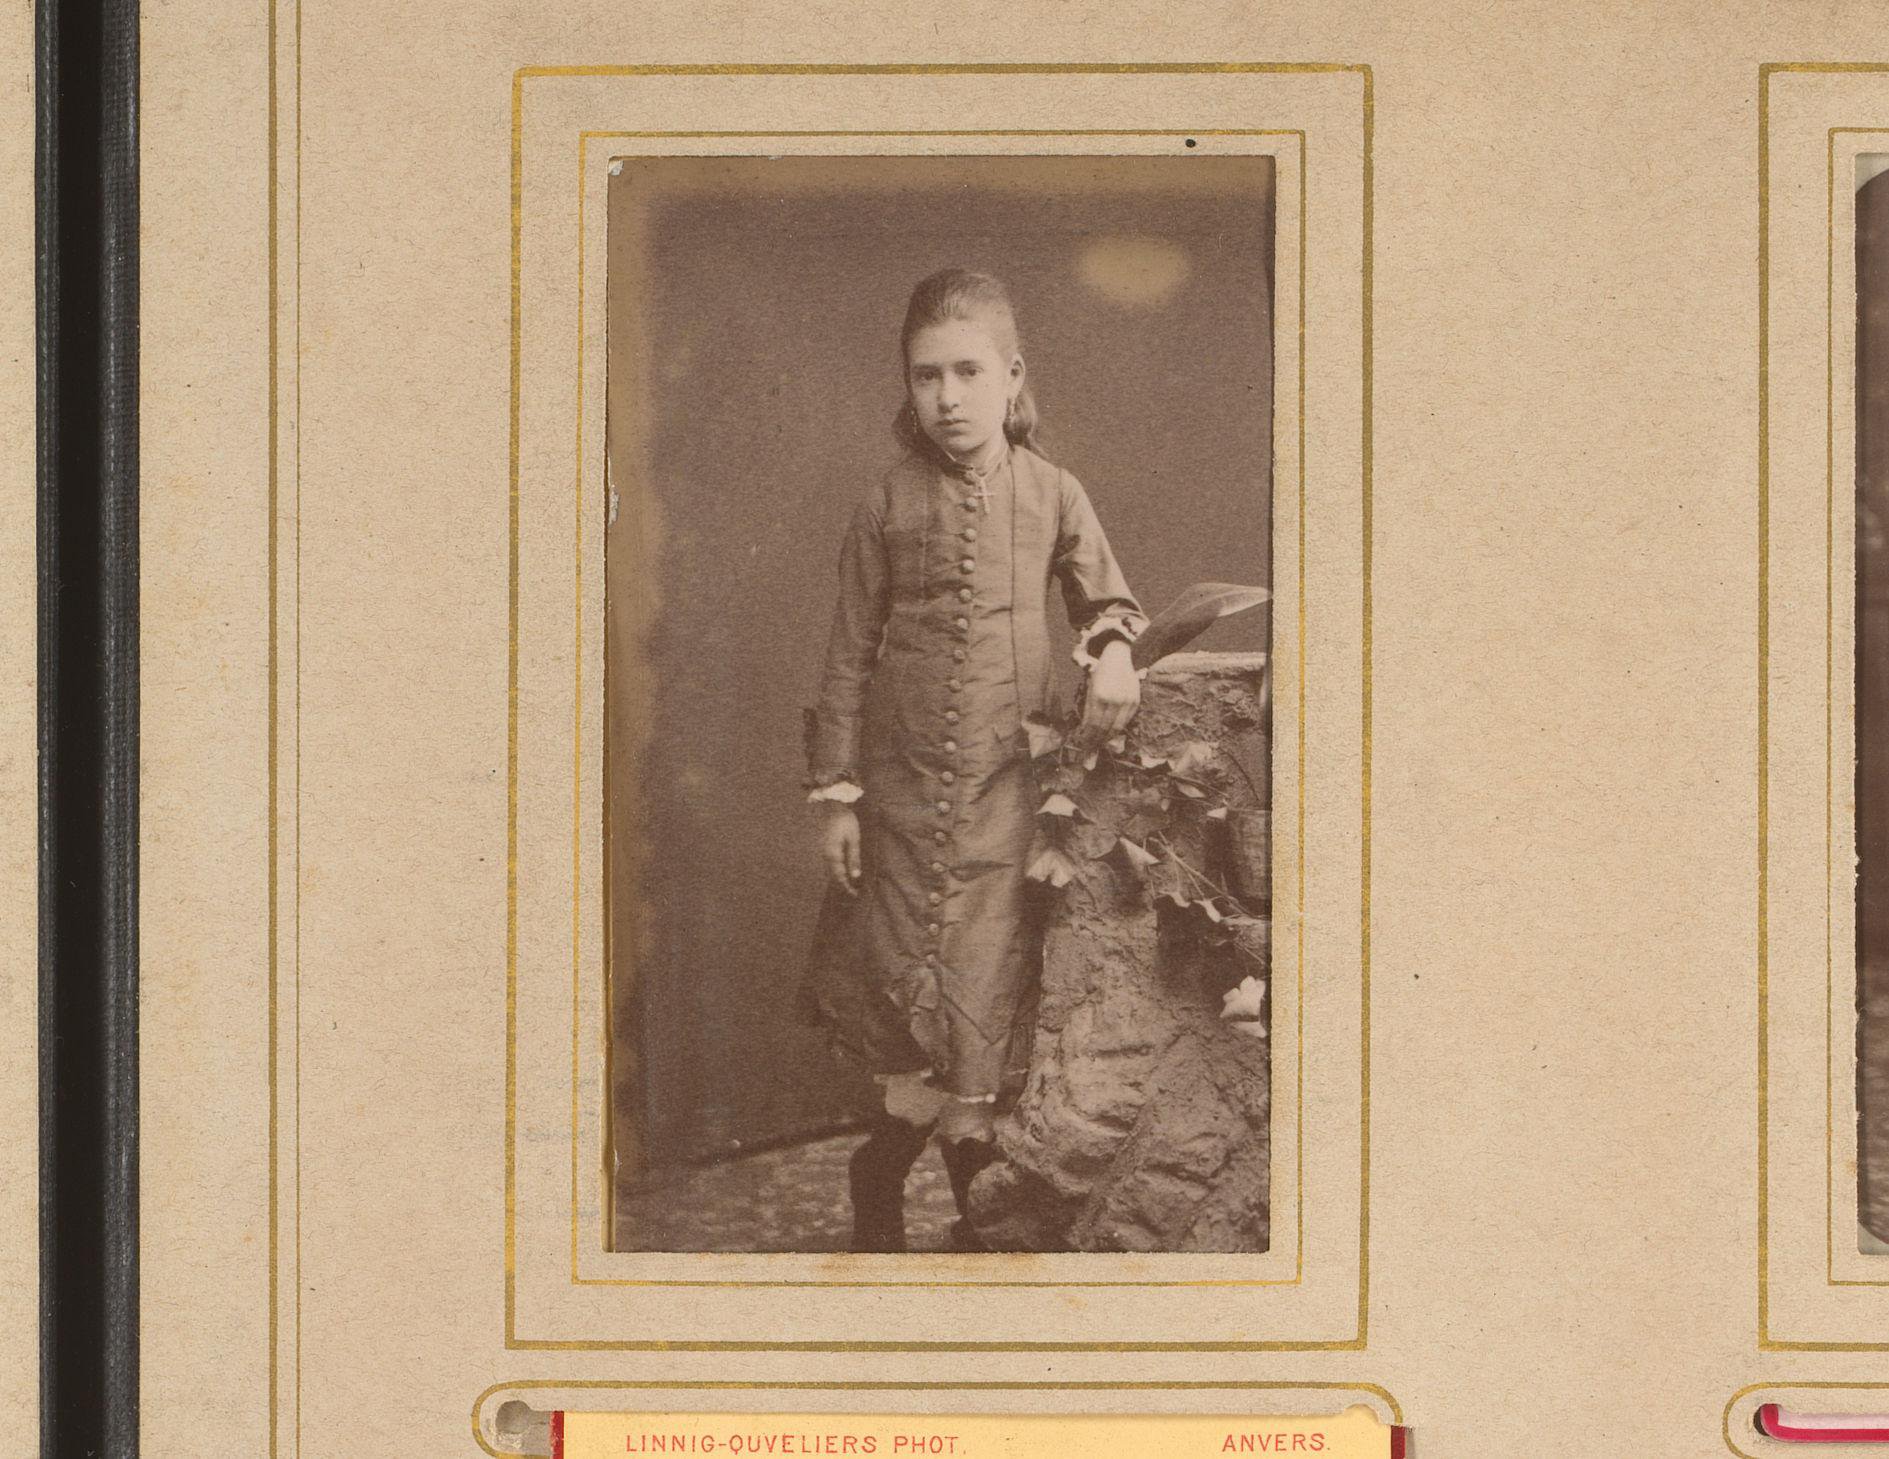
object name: album leaf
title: Portret van een meisje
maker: egide linnig-quveliers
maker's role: fotograaf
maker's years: 1844-1908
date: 1870-1900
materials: cardboard, photographic support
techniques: albumen print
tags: historical persons, girl (child between toddler and youth)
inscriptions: inscription: ‘Maison Linning-Quveliers/ Photographie/(...)’, name: ‘Lining-Quveliers Phot. Anvers’